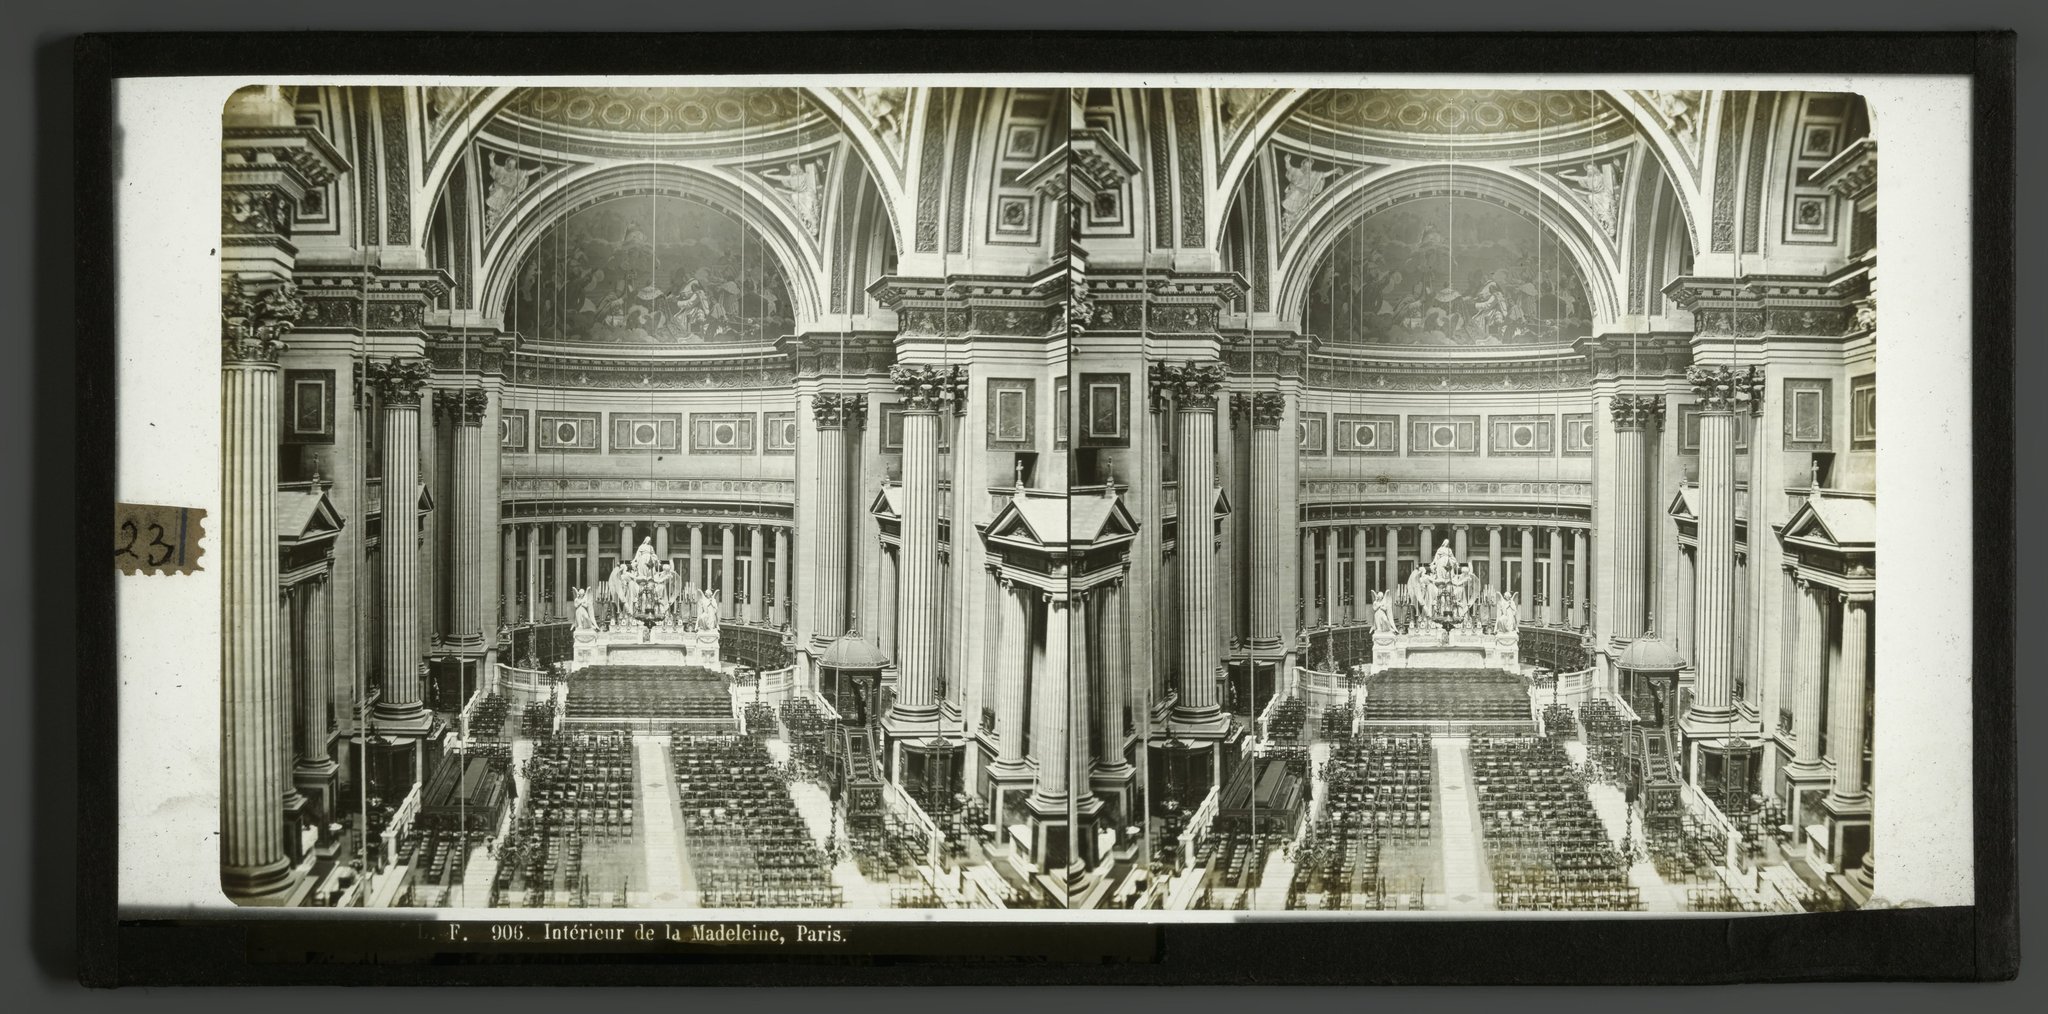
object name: stereoscopic photograph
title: Intérieur de la Madeleine, Paris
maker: l.f.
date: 1856-1890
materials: glass, paper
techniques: slide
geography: paris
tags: parts of church interior: nave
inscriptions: number: ‘23’, number: ‘L. F. 906’